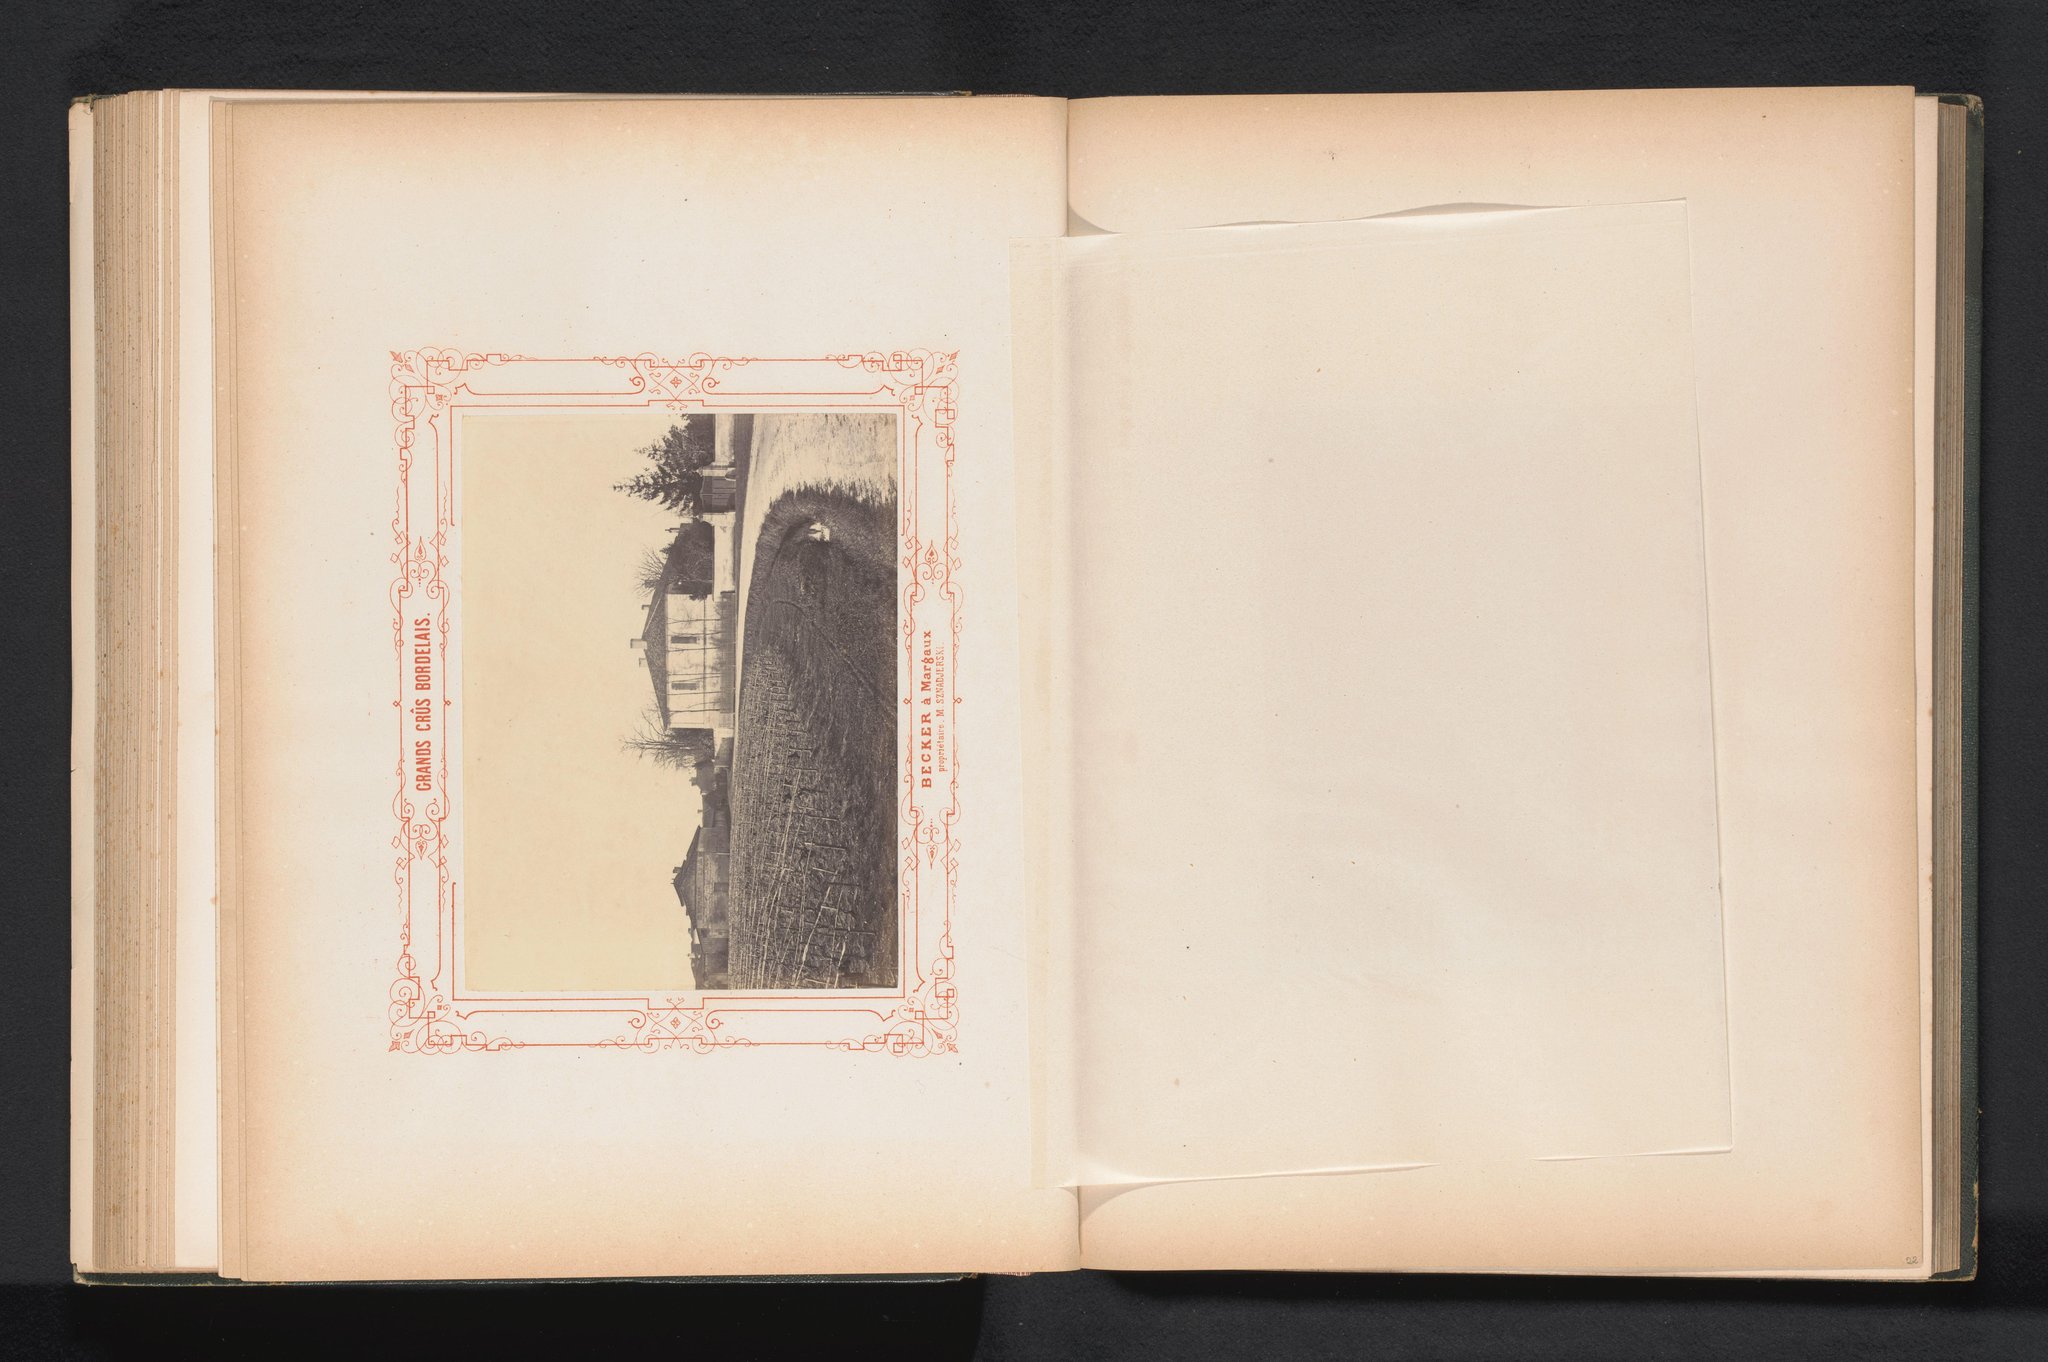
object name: photograph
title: Grands Crûs Bordelais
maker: alfred danflou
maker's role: fotograaf, schrijver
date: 1862-1867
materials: photographic support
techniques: albumen print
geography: margaux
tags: castle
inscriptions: inscription: ‘propriétaire: M. SZNADJERSKI.’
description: Foto op zevende ongenummerde pagina na pagina 83.